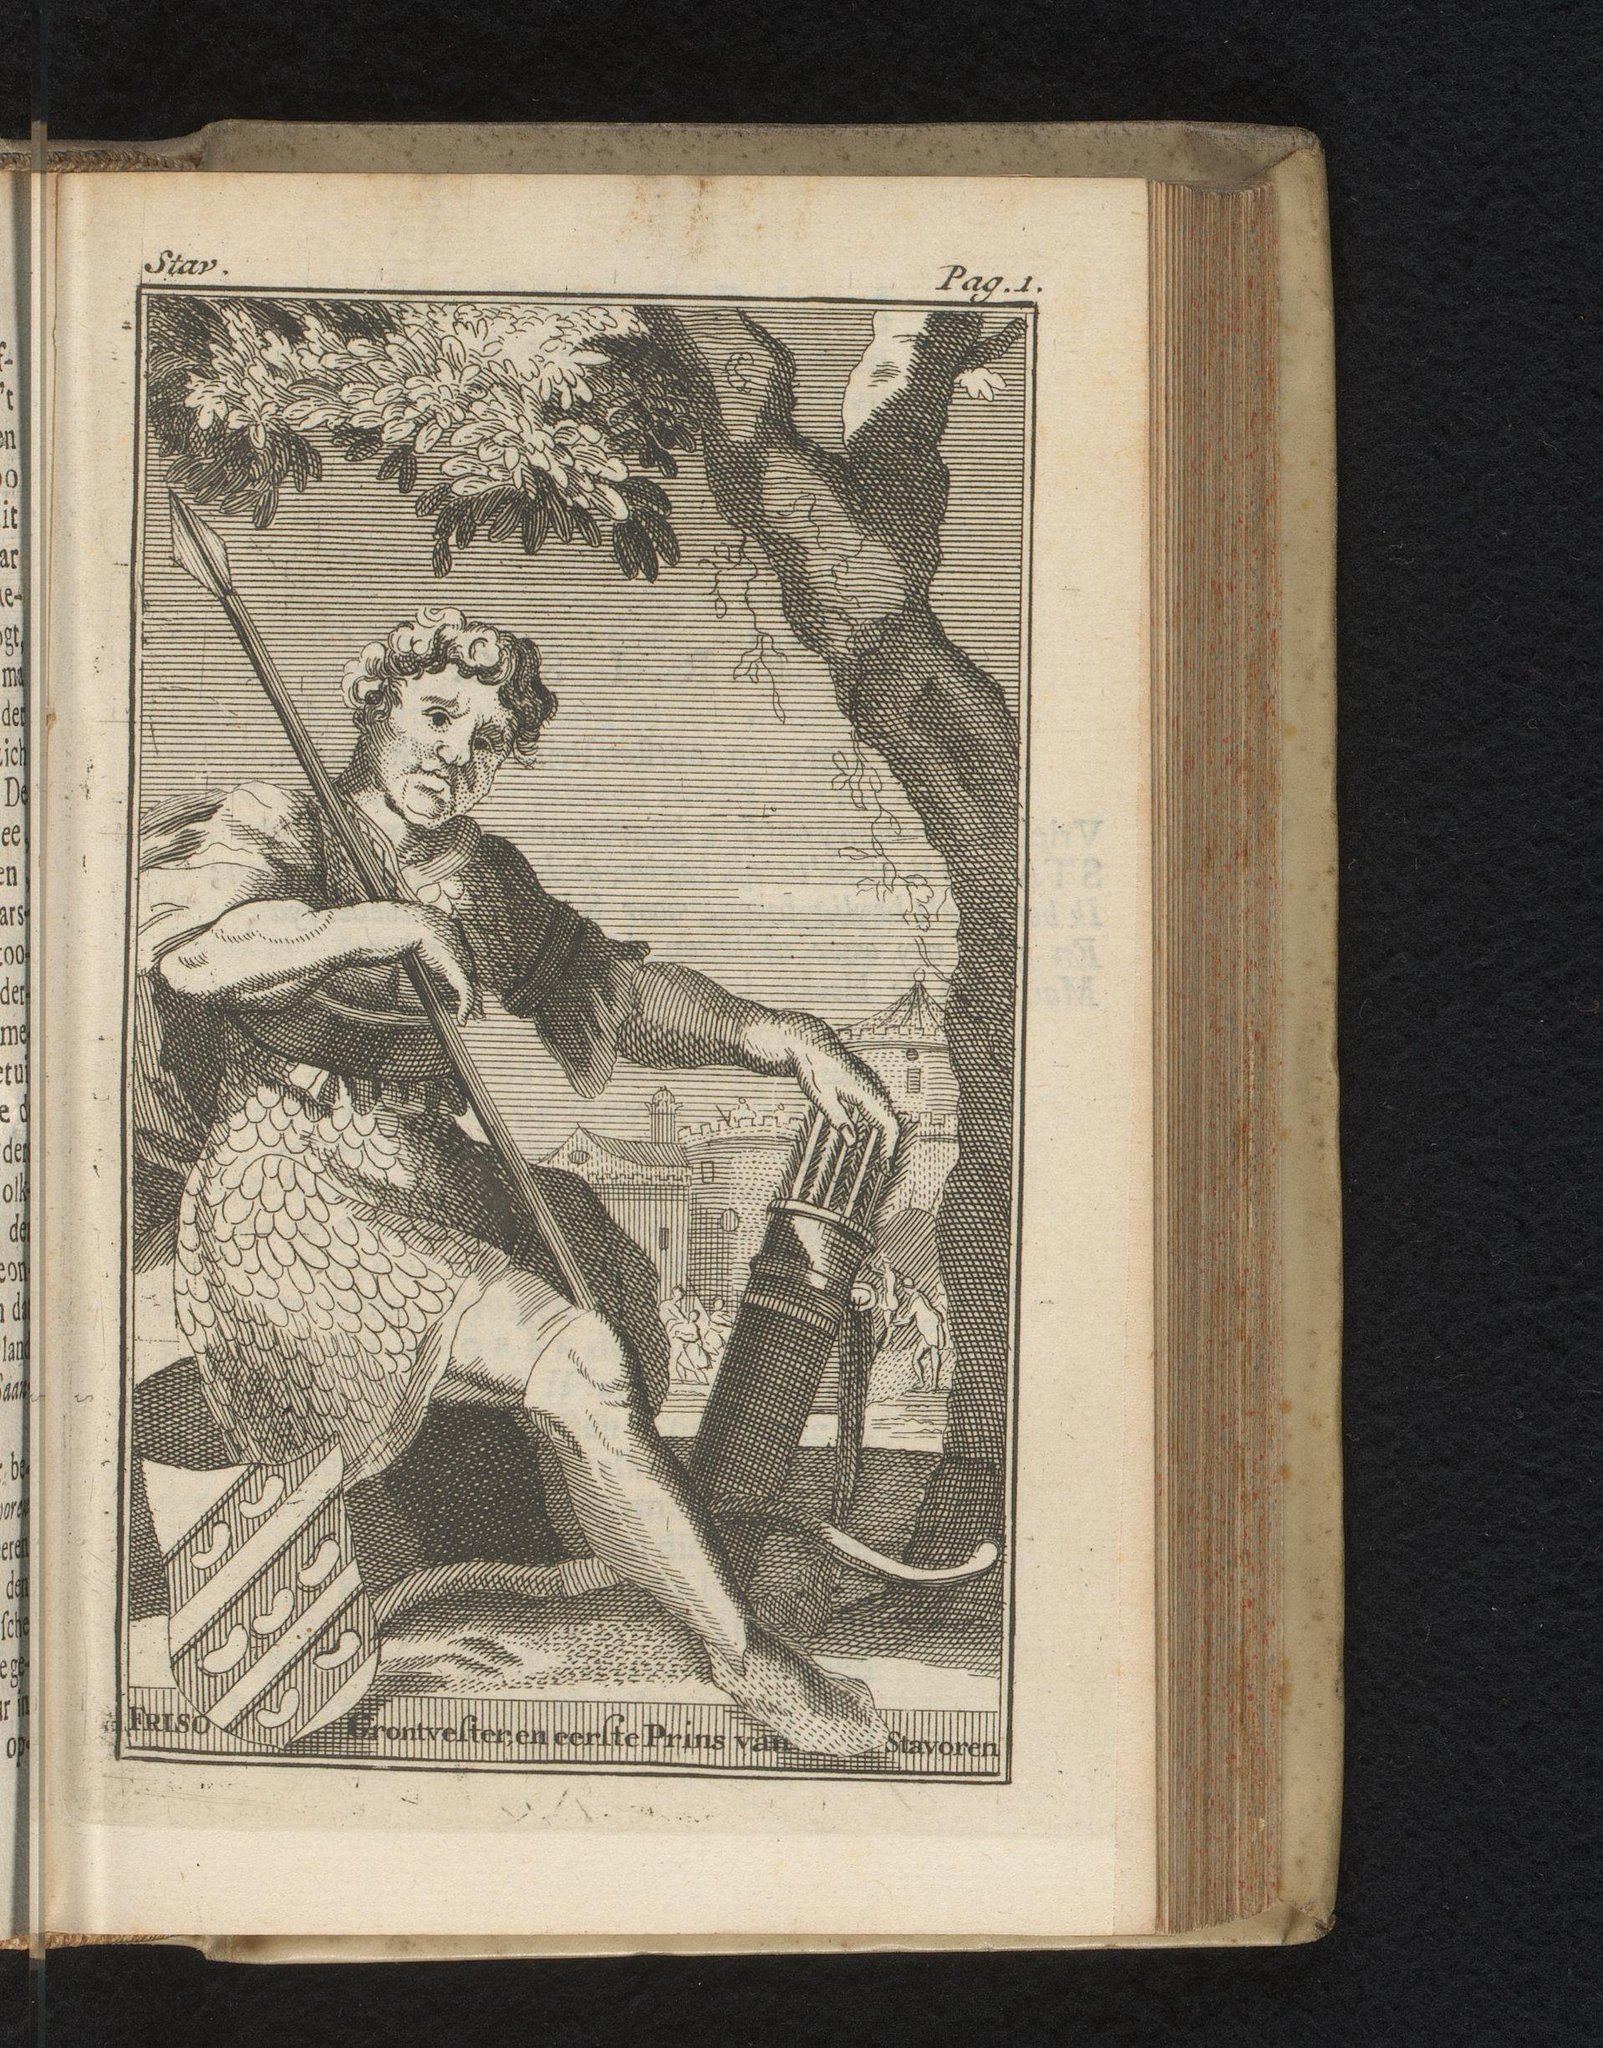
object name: history print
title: Oud-heden van Zaan-land, Stavoren, Vronen en Waterland : deze laatste druk (...) met nodige aanteekeningen, figuren, en een landkaart verrykt / Op- en neder-gank van Stavoren, in VI. Boeken verdeelt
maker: pieter van den berge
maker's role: draughtsman, print maker, printer, publisher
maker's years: 1659-1737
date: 1700-1702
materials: paper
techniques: etching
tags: stamvader der friezen friso, stavoren, romeinse periode in nederland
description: Illustratie in: H. Soeteboom, Oud-heden van Zaan-land, Stavoren, Vronen en Waterland : deze laatste druk ... met nodige aanteekeningen, figuren, en een landkaart verrykt / Op- en neder-gank van Stavoren, in VI. Boeken verdeelt, W. Linnig van Koppenol, Amsterdam 1702, ingebonden tussen p. 2/3.